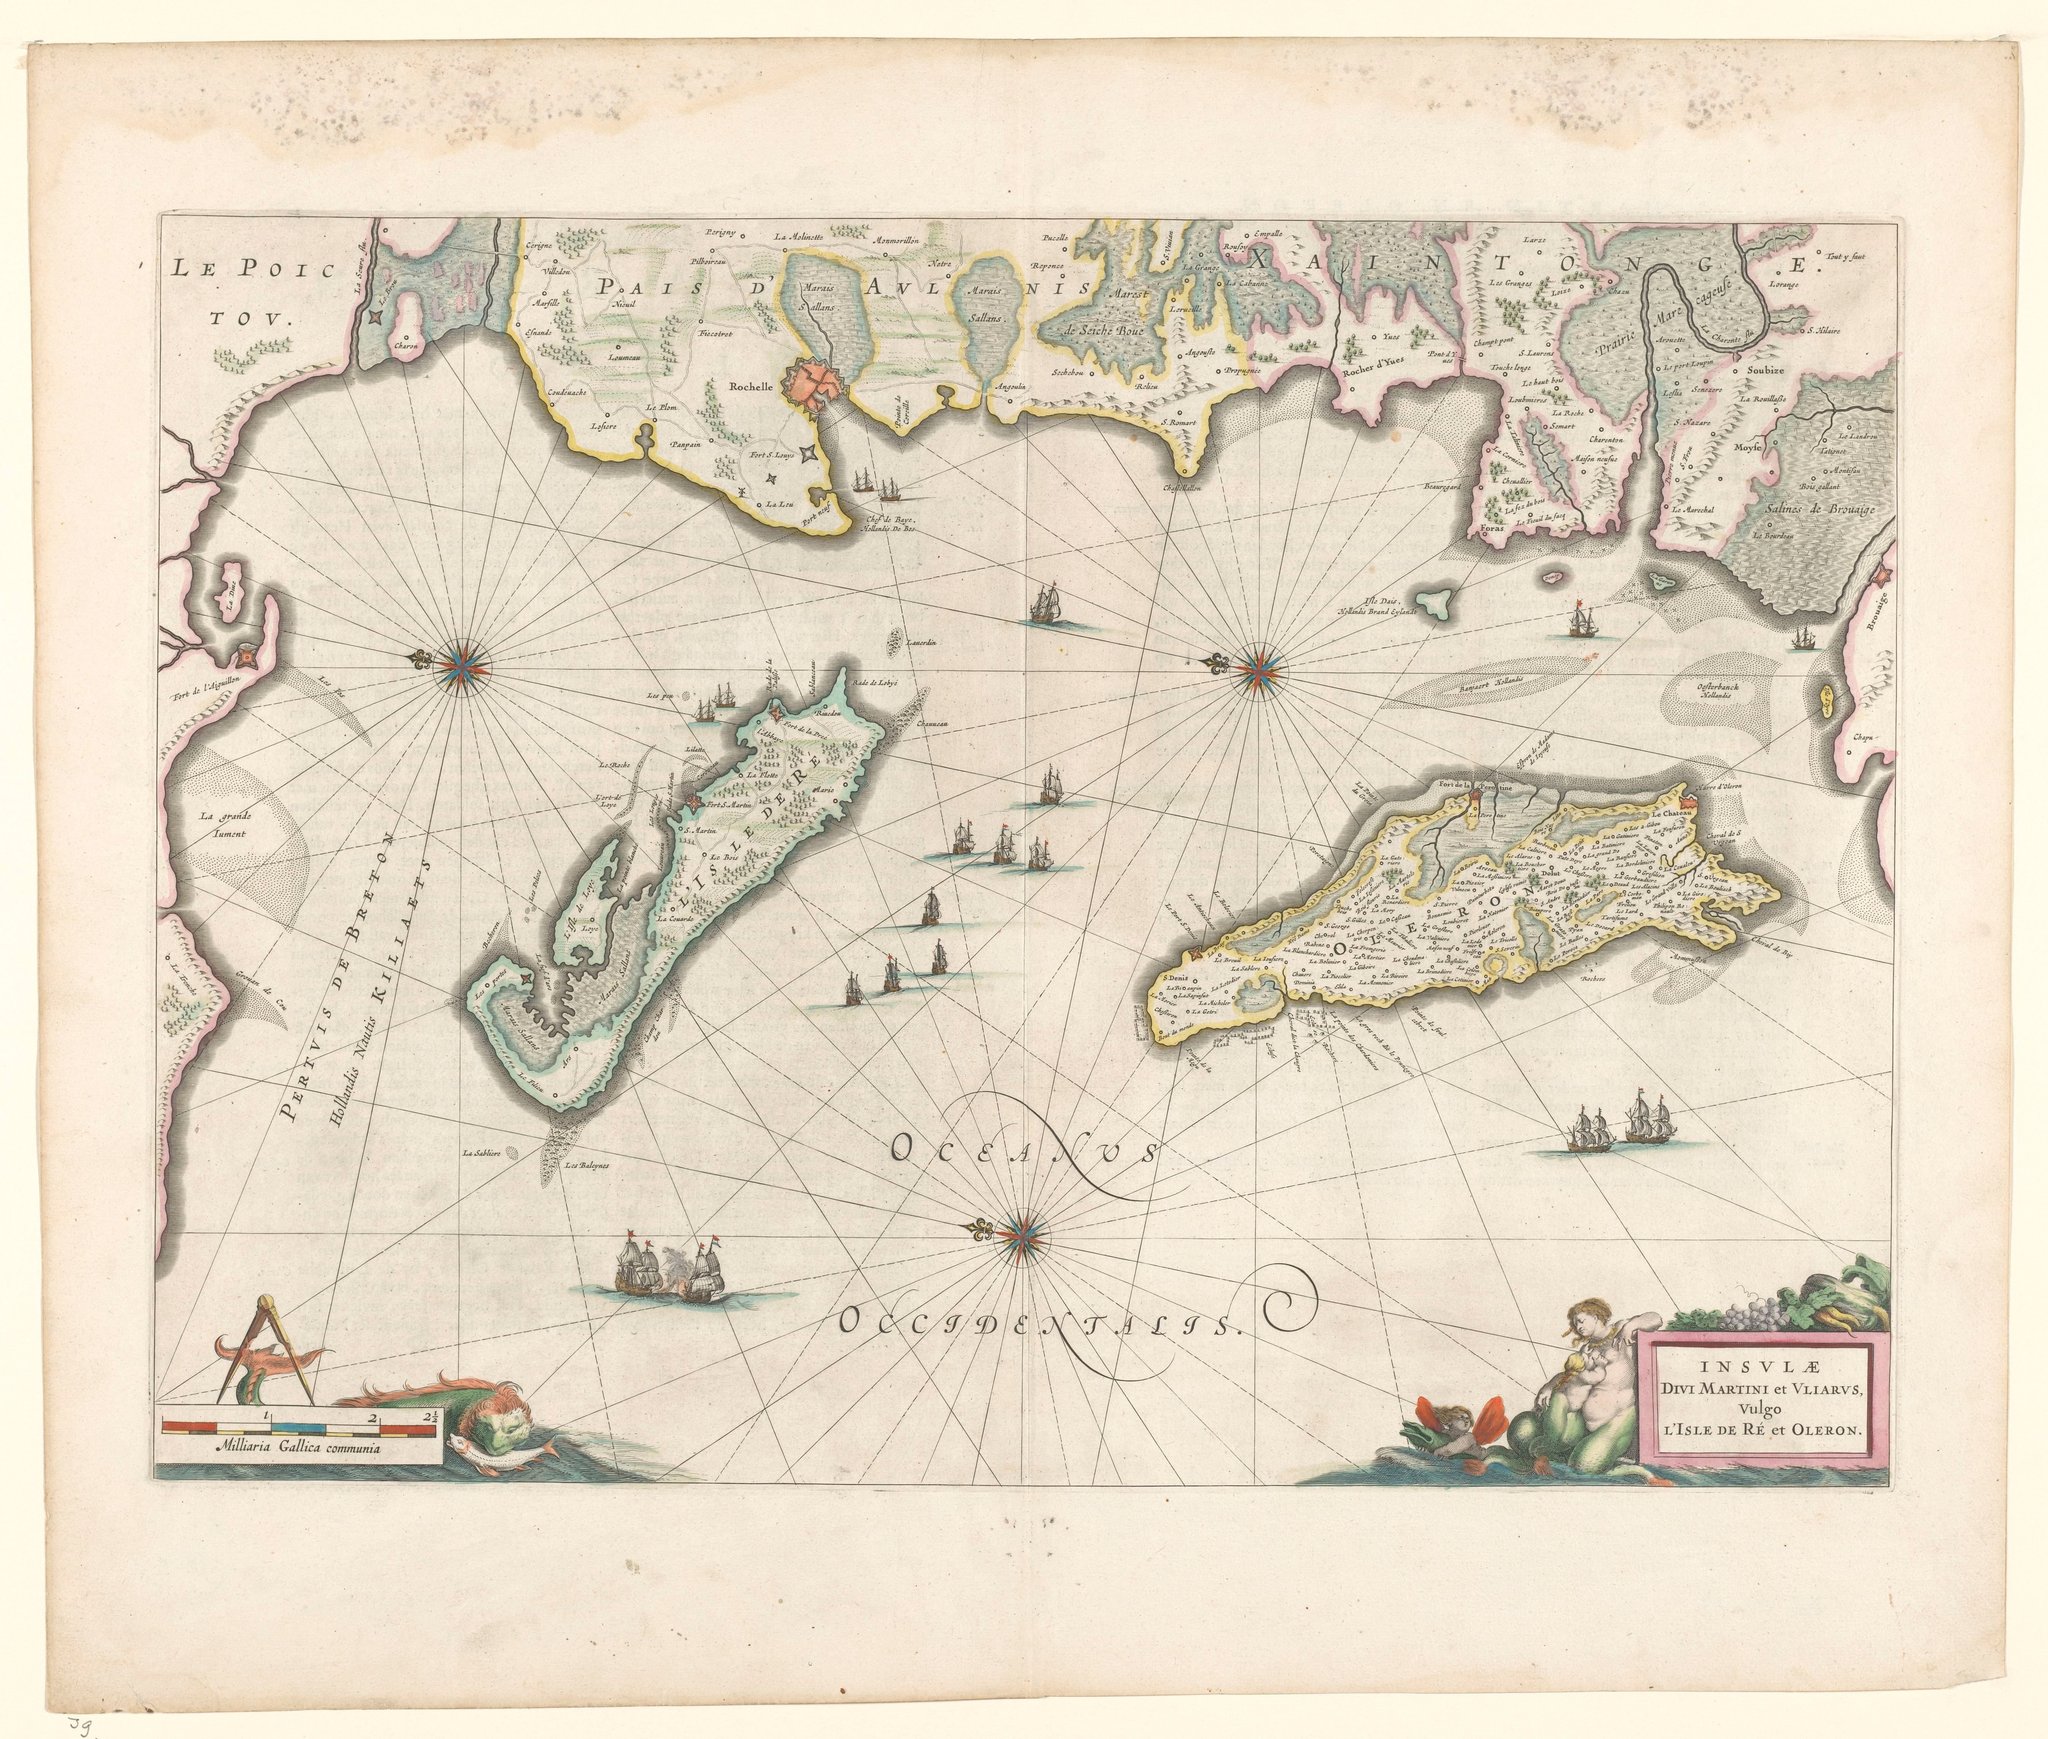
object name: map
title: Kaart van Franse kust bij La Rochelle en de eilanden Ré en Oleron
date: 1600-1650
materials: paper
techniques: colour, engraving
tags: maps of separate countries or regions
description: Kaart van de eilanden Ré en Oleron en de Franse kust, grenzen en kusten gekleurd. Drie windrozen, r.b, m.o. en l.b. Het noorden ligt links. Schepen in zee. L.o. schaal in Franse mijlen met zeemonster en passer. R.o. bij opschrift allegorische figuren. Verso: 2 pagina's tekst, 2 kolommen ieder. Opschrift; r.o.: INSLAVAE / DIVI MARTINI et VLIARVS, Vulgo / L'ISLE DE RE et OLERON.